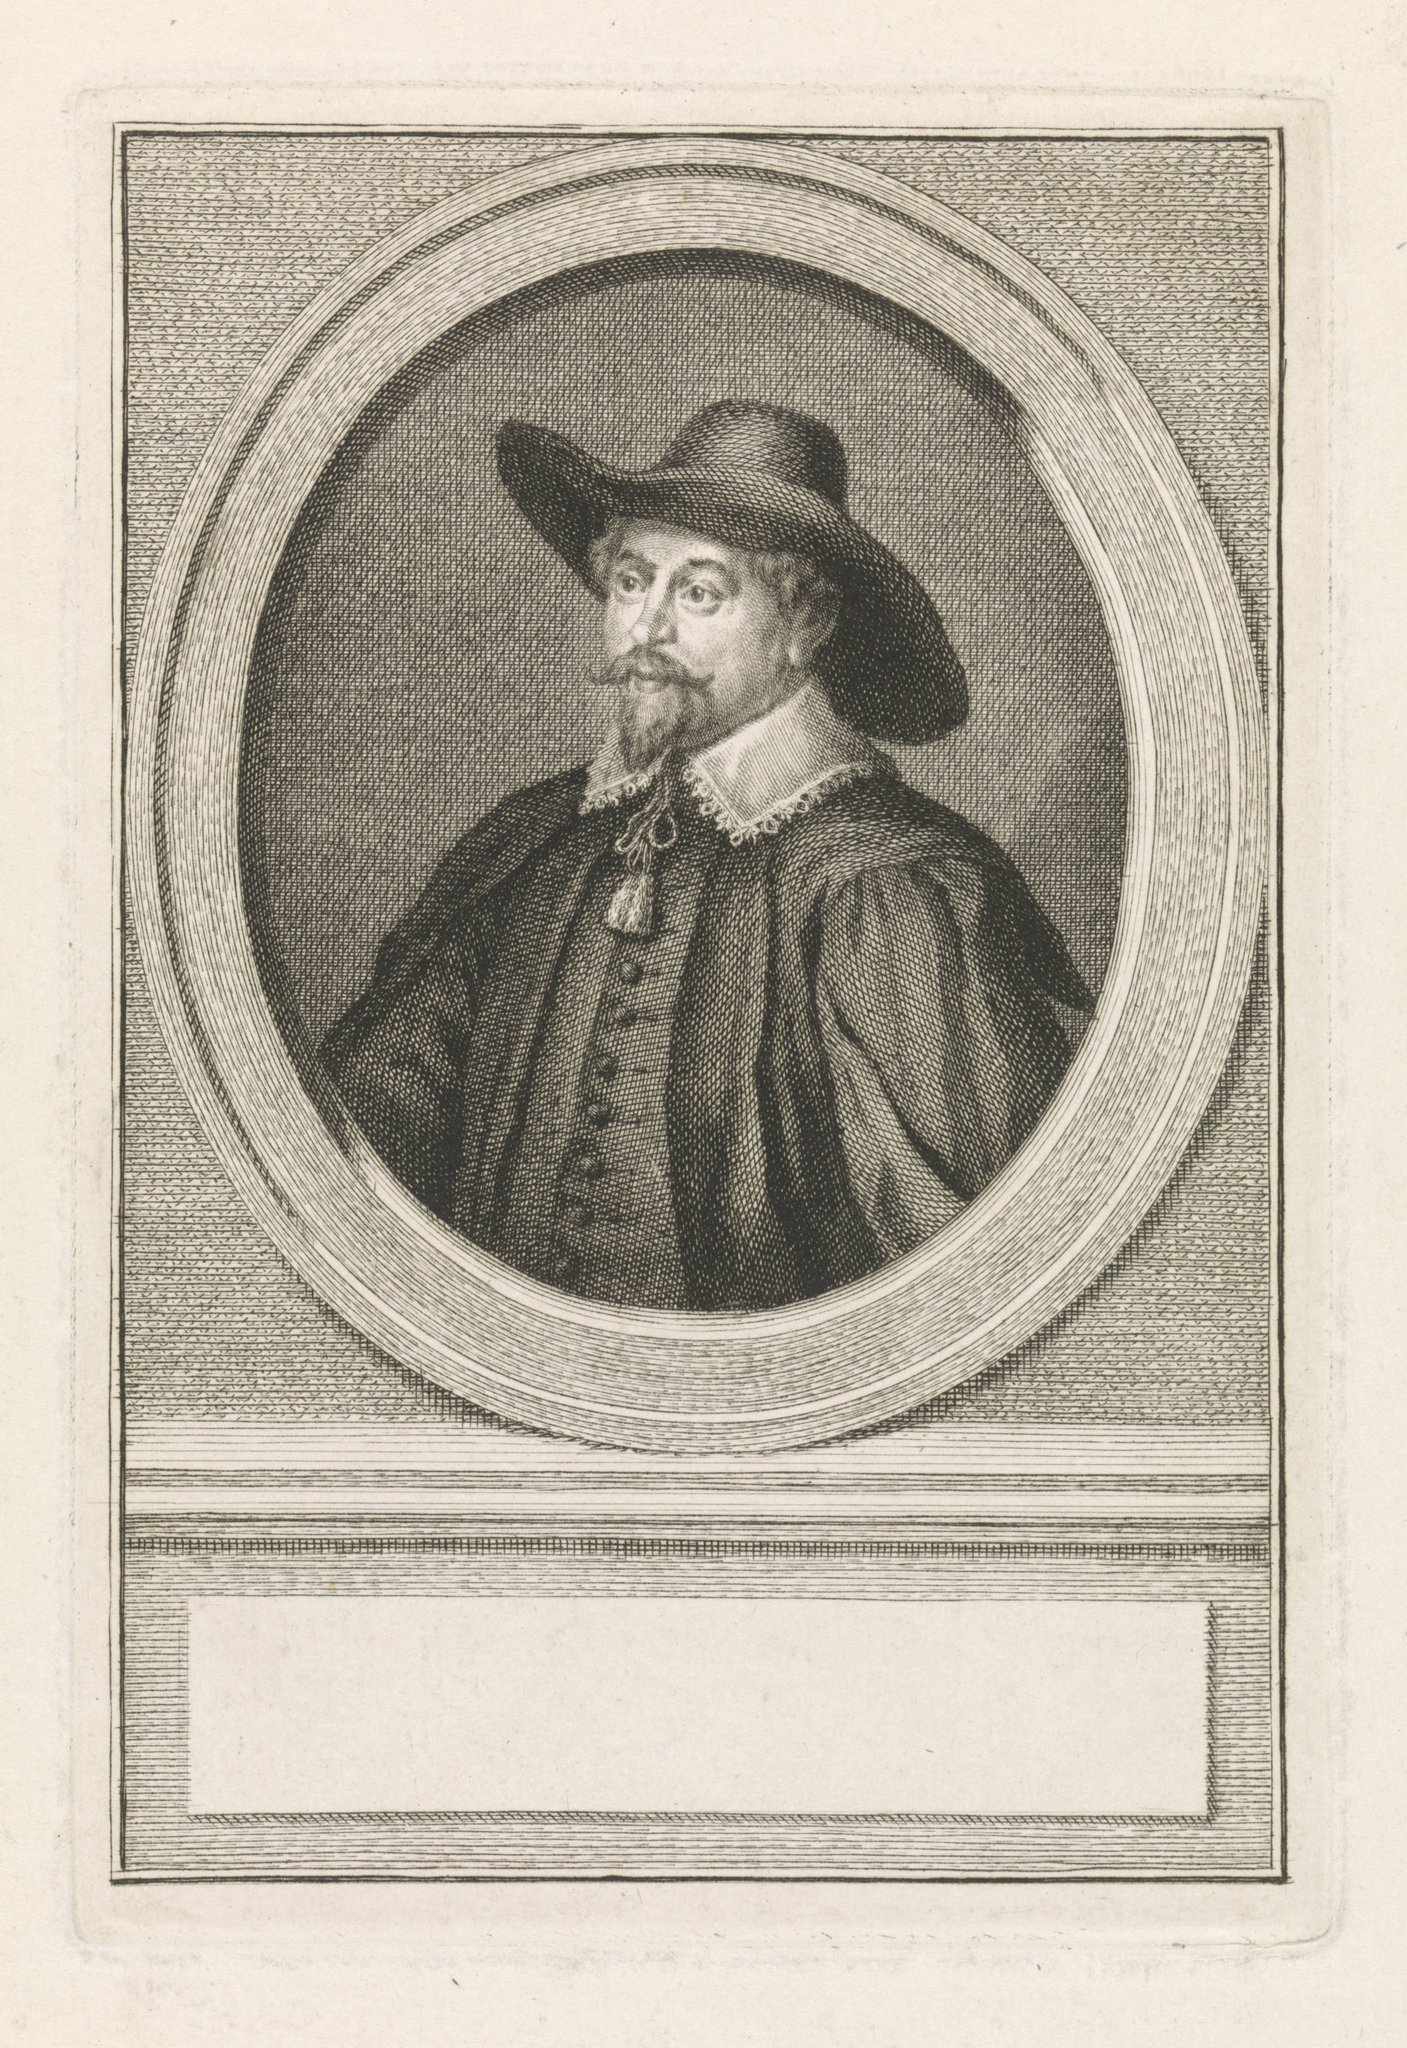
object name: print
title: Portret van Nicolaes Tulp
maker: jacob houbraken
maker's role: draughtsman, print maker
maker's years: 1698-1780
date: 1749-1780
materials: paper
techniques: engraving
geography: amsterdam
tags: amsterdam, the hague, mayor, historical persons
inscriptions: collector's mark: Lugt 2228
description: Latere staat van deze prent is oorspronkelijk bedoeld als aanvulling op Jan Wagenaars ‘Vaderlandsche historie’* en was zo vanaf 1796 verkrijgbaar bij Johannes Allart te Amsterdam. Voor de advertentie waarin Allart de 60 portretten en 7 platen, allen gegraveerd door Houbraken, ter aanvulling op Wagenaars ‘Vaderlandsche historie’ aanbiedt, zie RP-P-OB-77.766. *Van dit werk zijn in de achttiende eeuw meerdere uitgaves verschenen, zoals: Wagenaar, Jan. Vaderlandsche historie, vervattende de geschiedenissen der Vereenigde Nederlanden (…). 21 delen. Amsterdam: Isaak Tirion, 1749-1759. Wagenaar, Jan. Vaderlandsche historie, vervattende de geschiedenissen der nu Vereenigde Nederlanden (…). 21 delen. Amsterdam: weduwe Isaak Tirion, 1770. Wagenaar, Jan. Vaderlandsche historie, vervattende de geschiedenissen der nu Vereenigde Nederlanden (…). 21 delen. Amsterdam, Leiden, Dordrecht en Harlingen: P. Schouten e.a., 1782. Wagenaar, Jan. Vaderlandsche historie, vervattende de geschiedenissen der nu Vereenigde Nederlanden (…). 21 delen. Amsterdam: Johannes Allart, 1790-1796.